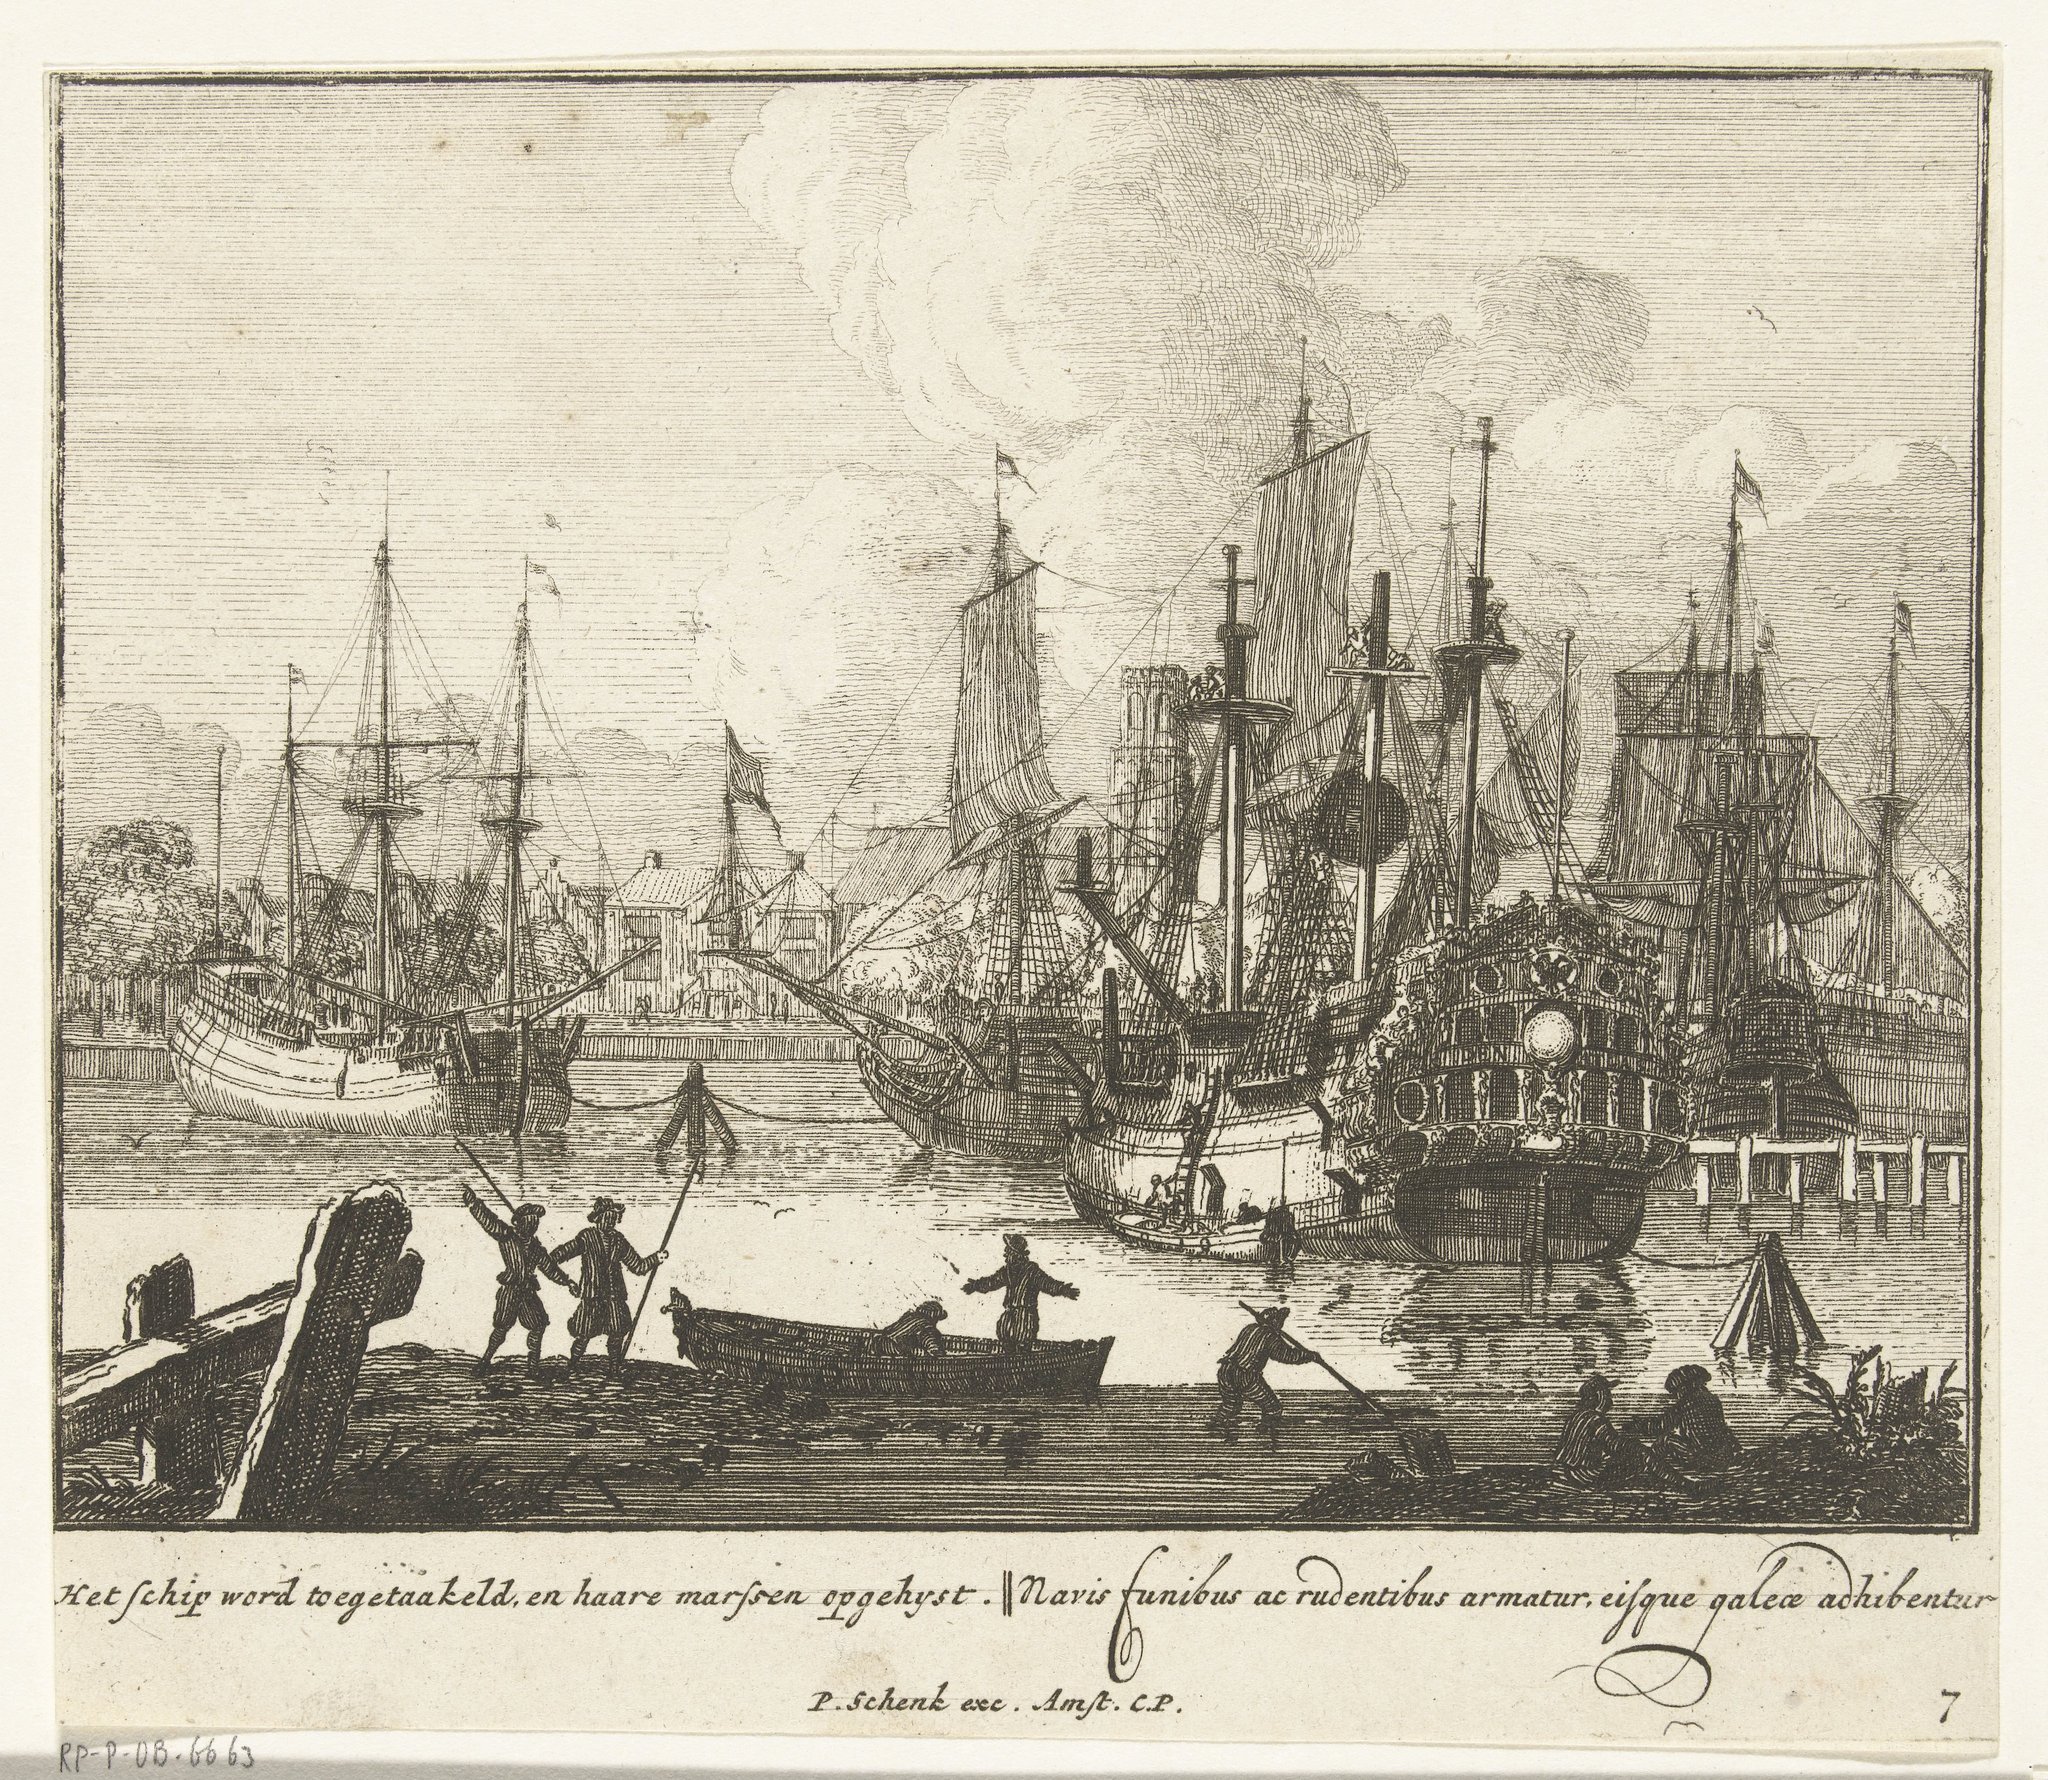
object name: print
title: Het aanbrengen van de takeling en de marsen, plaat nr. 7, ca. 1700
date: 1690-1710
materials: paper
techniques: etching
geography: northern netherlands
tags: building a ship, ship under construction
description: Het aanbrengen van de takeling en de marsen op het schip. No. 7 uit serie van 16 prenten waarop de bouw en lotgevallen van een schip zijn afgebeeld. Met onderschriften in het Nederlands en Latijn.